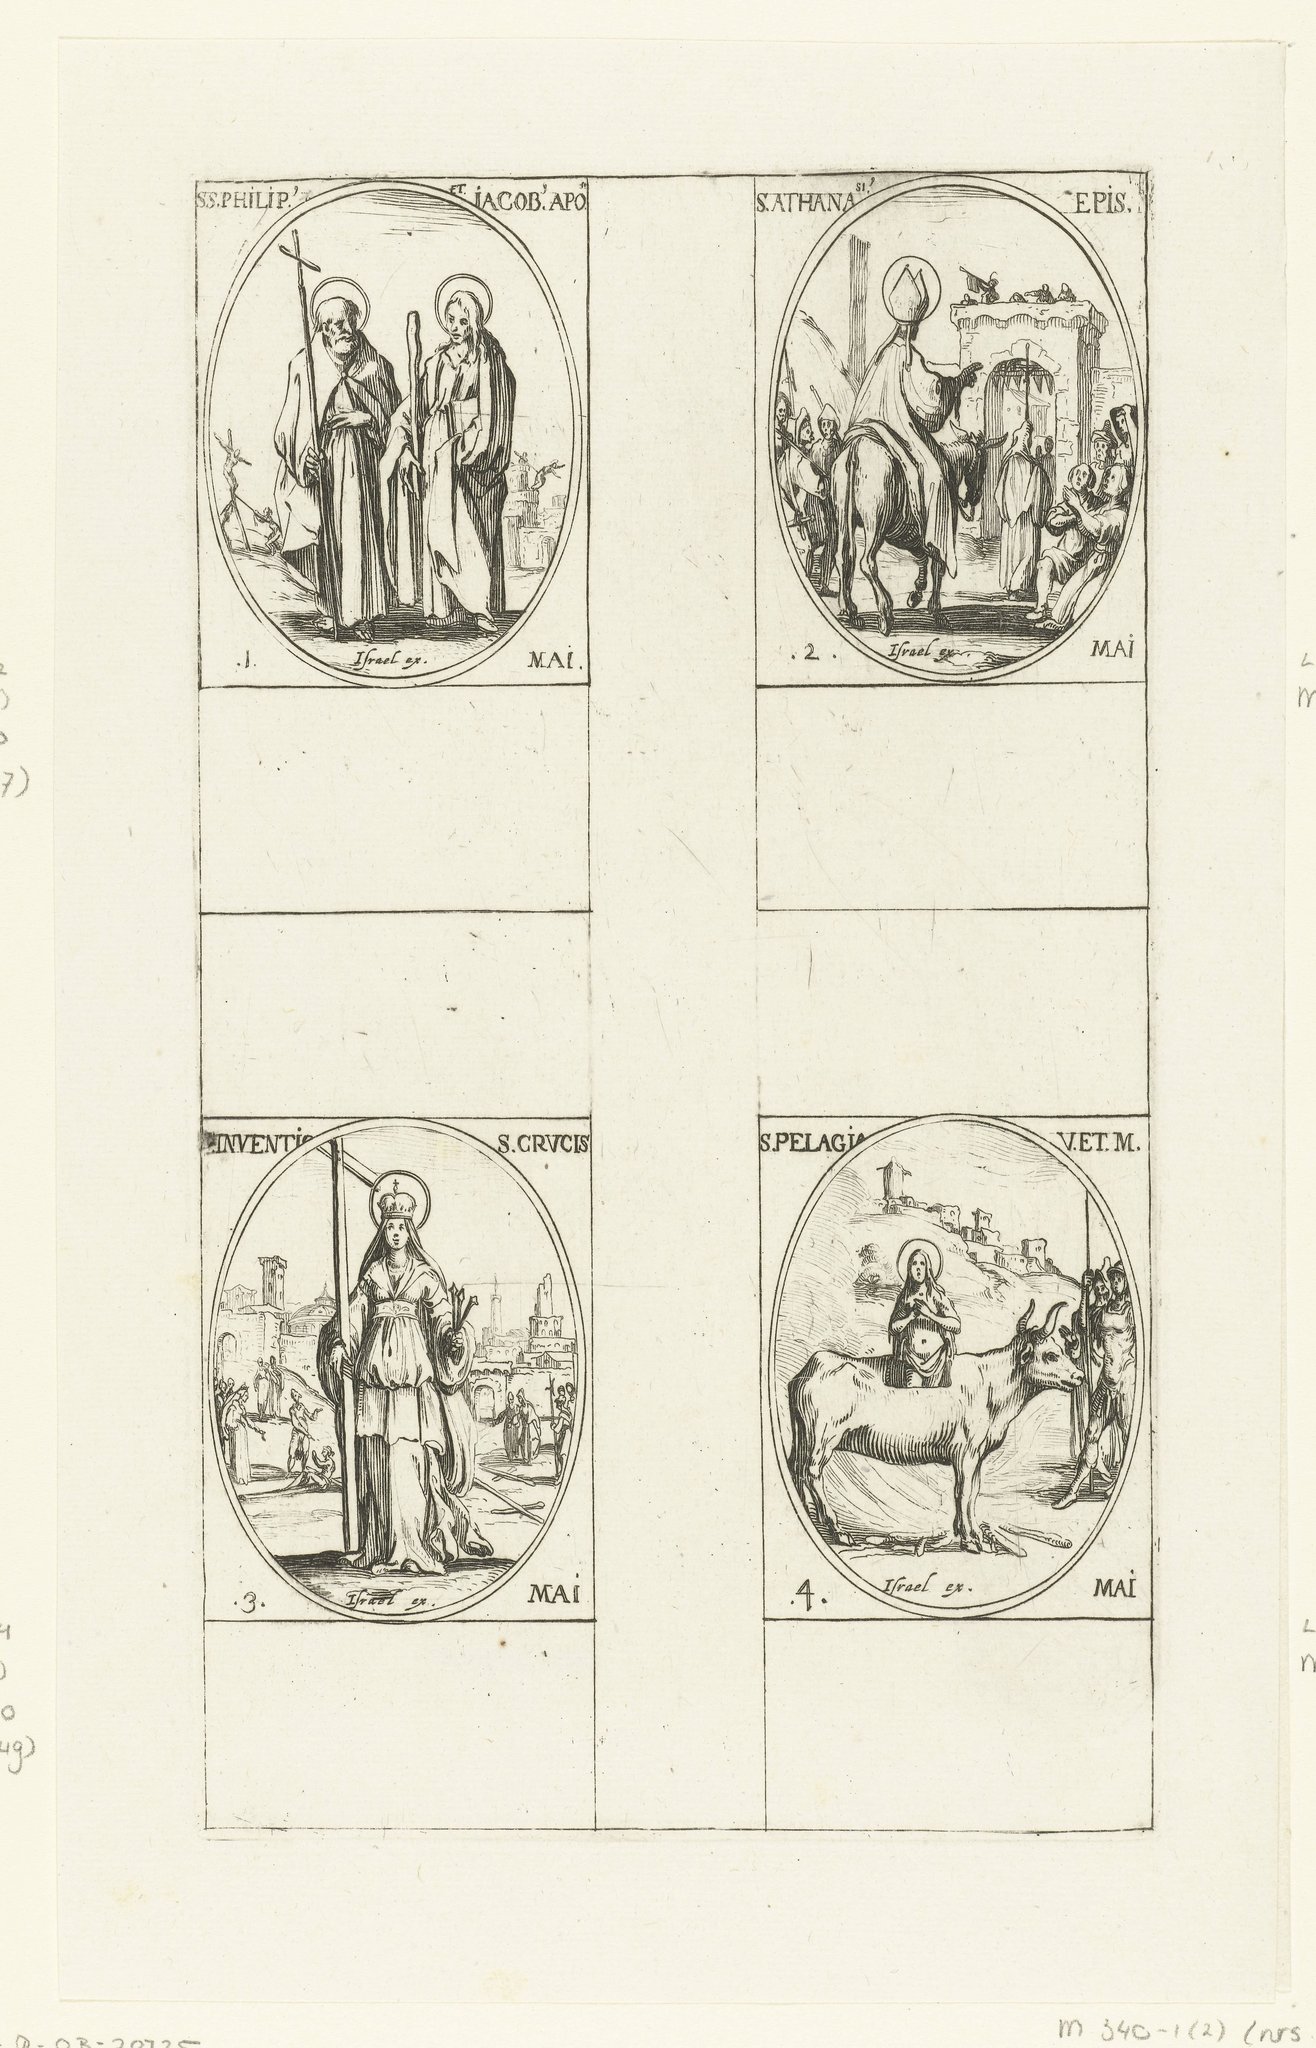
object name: print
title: Alle heiligen en de Christelijke feestdagen van het jaar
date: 1632-1636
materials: paper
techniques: etching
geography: paris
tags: empress helena, mother of constantine the great; possible attributes: model of church, (royal) crown, crown of thorns, cross, three nails, the apostle james the less, first bishop of jerusalem; possible attributes: book, fuller's club, scroll, the apostle philip; possible attributes: book, cross, dish with snake, lance, scroll, stone, sword, helena identifies the true cross: a human corpse is restored to life when it touches the cross, female saints (with name), athanasius the great, bishop of alexandria; possible attributes: book, heretic under feet, scroll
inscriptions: collector's mark: Lugt 240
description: Blad met vier ovale voorstellingen, elk met opschrift en datum in het Latijn: linksboven de apostelen Filippus met kruisstaf en Jakobus de Mindere met knuppel naast elkaar, rechtsboven de Heilige Anastasius te paard bij een poort, linksonder de Heilige Helena met het kruis en de drie spijkers, rechtsonder de Heilige Pelagia in een stier die boven een vuur staat. Deze prent is onderdeel van een serie prenten met voorstellingen van de heiligen en de christelijke feestdagen van het jaar. Er zijn steeds vier scènes van één plaat op één blad gedrukt. Inclusief bijbehorend titelblad en frontispice gaat het in totaal om 124 platen (490 voorstellingen). De drie platen met de laatste 12 scènes (de veranderlijke christelijke feestdagen) zijn in de derde staat versneden tot 12 kleine plaatjes, en met een apart titelblad uitgegeven.